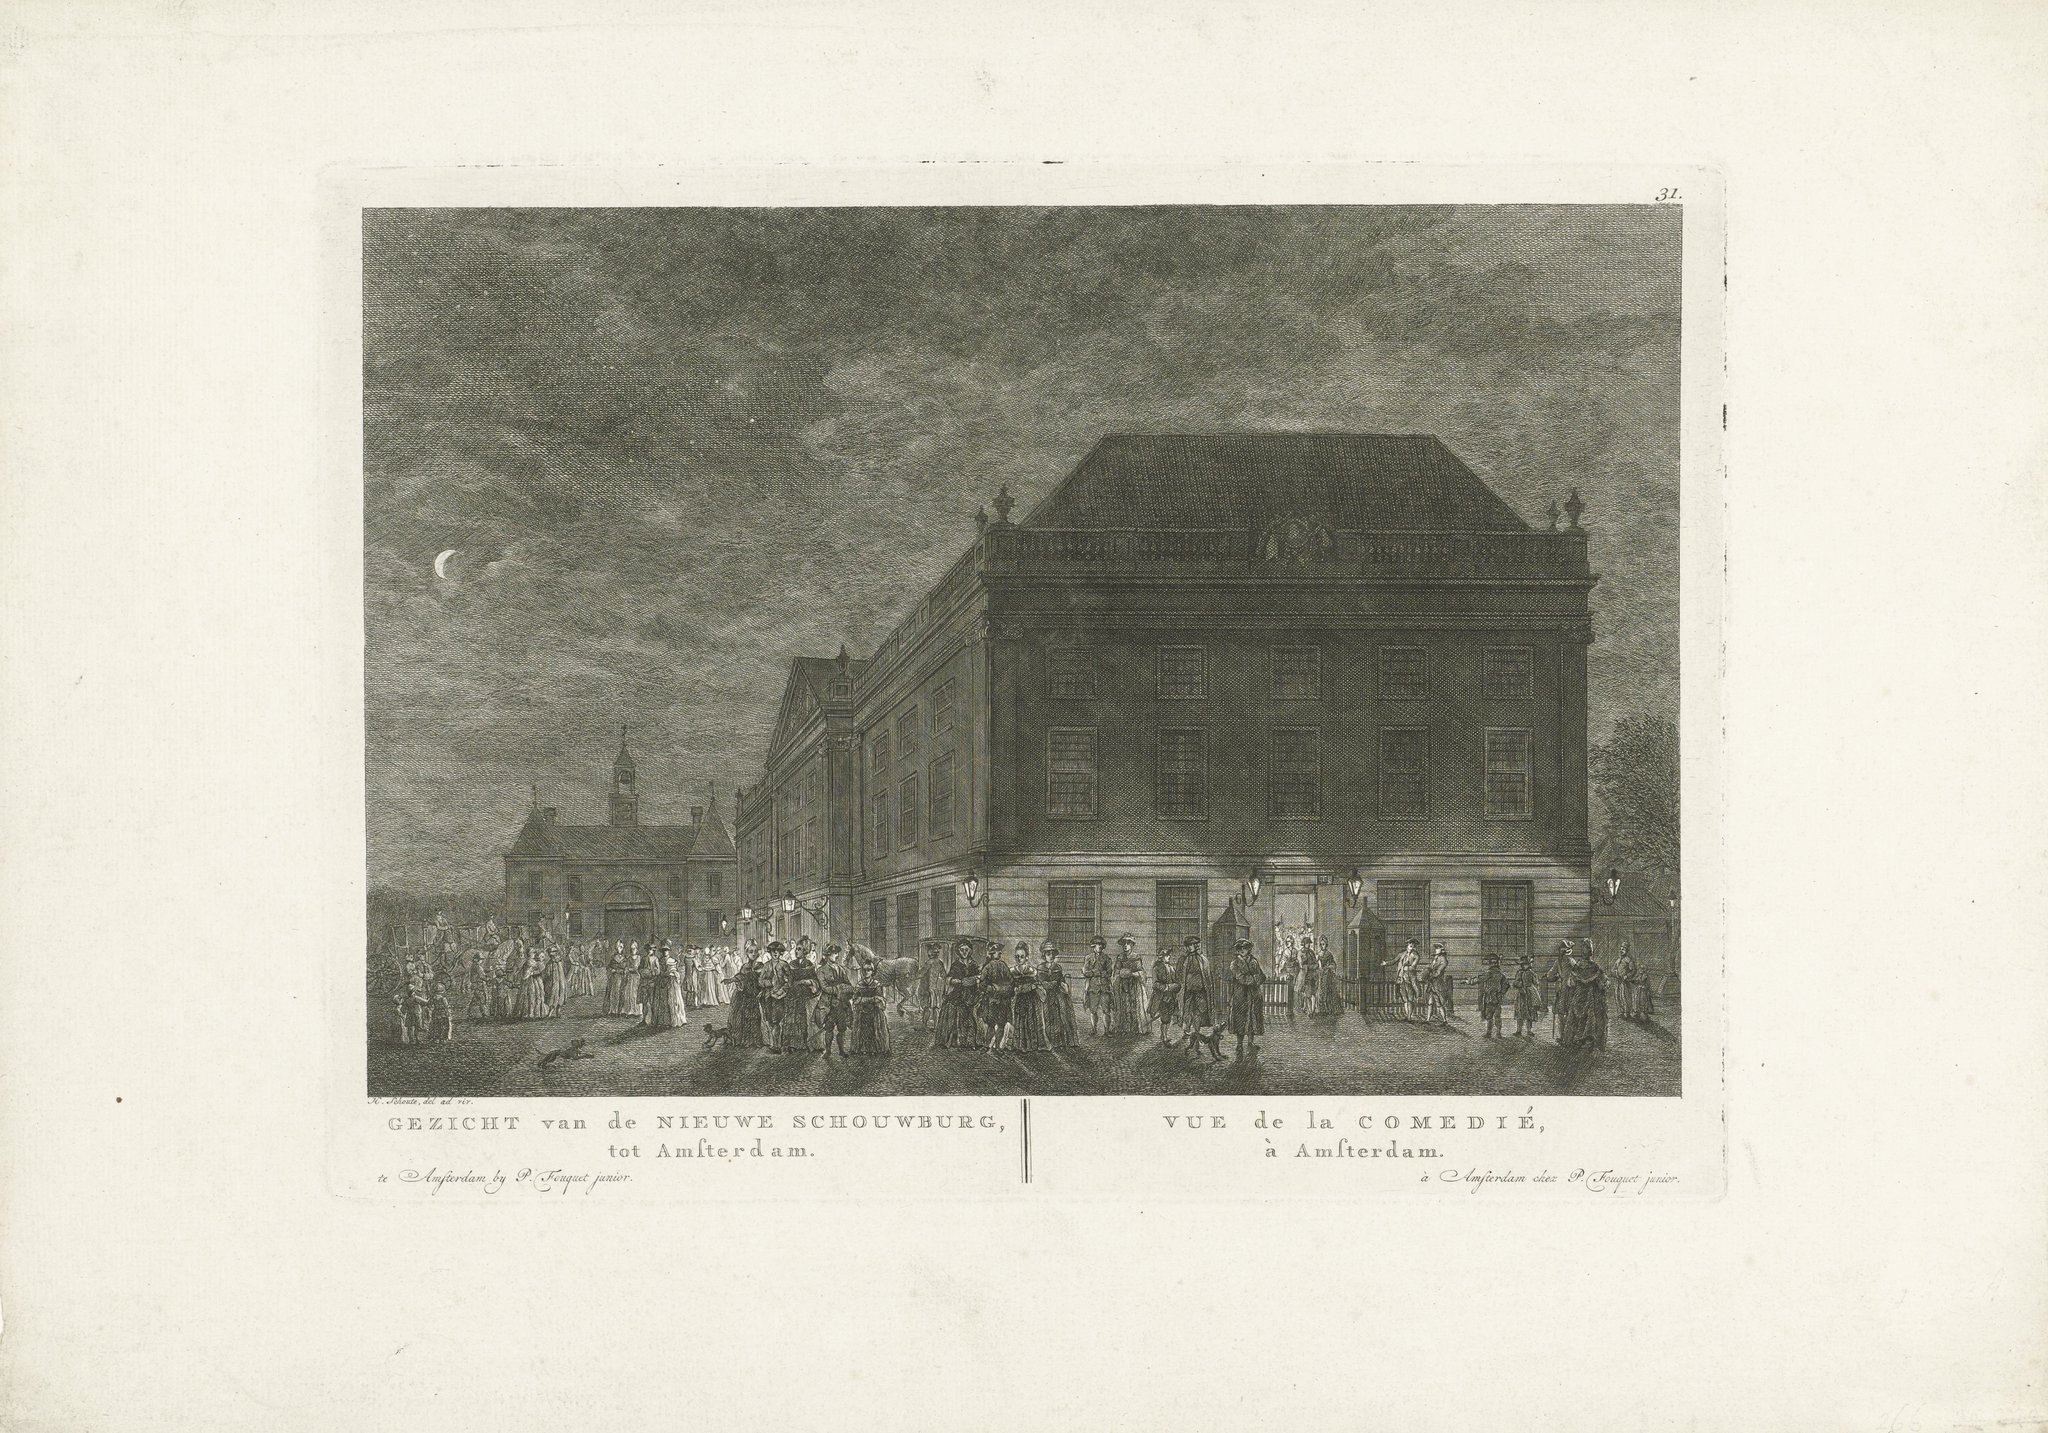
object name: print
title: Gezicht van de Nieuwe Schouwburg, tot Amsterdam / Vue de la Comedié, à Amsterdam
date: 1774-1783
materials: paper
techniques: engraving, etching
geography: amsterdam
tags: theatre (building), city-gate, square, place, circus, etc. (+ city(-scape) with figures, staffage)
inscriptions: collector's mark: Lugt 2233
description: Deze prent is ook gebruikt in de zogenaamde Atlas van Fouquet.* Pierre Fouquet gaf vanaf 1760 stadsgezichten van Amsterdam - naar tekeningen van verschillende kunstenaars, gemaakt door verschillende prentmakers - uit. Deze prenten werden aanvankelijk los of in series verkocht. Zoals toen gebruikelijk kon de koper de prenten zelf laten inbinden. Hiertoe gaf Fouquet tussen 1778 en 1783 een titelblad, plattegrond en inhoudsopgave van de tot dusver 100 uitgegeven prenten uit (1). Gezien de inhoud afhankelijk was van wat de koper had verzameld verschilt de inhoud van de verschillende bewaarde Fouquetatlassen onder deze titel sterk. Ook zijn er exemplaren bekend waar tevens andere prenten aan zijn toegevoegd. Omdat er behoefte bleek aan uitleg bij de platen werd in 1783 een nieuwe versie van de atlas uitgegeven, aangevuld met tekst en twee prenten. De aangegeven volgorde veranderde maar de platen van de al eerder uitgegeven prenten bleven ongewijzigd. Deze uitgave werd in opdracht van Fouquet gedrukt bij Daniël Jean Changuion en Petrus den Hengst (2). Een tiental platen werd bijgewerkt en verscheen, met nieuw impressum, in het vervolg van Wagenaars geschiedenis van Amsterdam, uitgeven door Petrus Conradi en Folkert van der Plaats (3). Een aantal jaar na het overlijden van Fouquet kwam Evert Maaskamp met een nieuwe uitgave van de atlas, met verbeterde tekst en toevoeging van twee prenten. Op alle platen verwijderde hij het oude en liet hij zijn eigen impressum zetten (4). De huidige staat van de prent komt voor in exemplaren van de onder (1) en (2) genoemde werken. * Onder de Atlas van Fouquet of Fouquetatlas verstaan we de hieronder vermelde publicaties (1), (2) en (4). (1). Afbeeldingen van de wyd-vermaarde koopstad Amsterdam benevens des zelvs voornaamste gebouwen en gezigten alle naar het leeven getekend / Receuil des edifices les plus considerables et des plus belles vues, de la fameuse ville d'Amsterdam, dessinées d'après nature. Amsterdam: Pierre Fouquet, 1778-1783. (2). Nieuwe atlas, van de voornaamste gebouwen en gezigten der stad Amsterdam, met derzelver beknopte beschryvingen. 2 delen. Amsterdam: Daniël Jean Changuion en Petrus den Hengst [in opdracht van Pierre Fouquet], 1783. (3). Stijl, Simon. Amsterdam, in zyne geschiedenissen, voorregten, koophandel, gebouwen, kerkenstaat, schoolen, schutterye, gilden en regeeringe, beschreeven. Om te dienen ten vervolge op het werk van Jan Wagenaar (…). 10 delen. Amsterdam en Harlingen: Petrus Conradi en Folkert van der Plaats, 1788-1801. (4). Nieuwe atlas, van de voornaamste gebouwen en gezigten der stad Amsterdam. Met derzelver beknopte beschryvingen. Amsterdam: Evert Maaskamp, 1805. * Het aantal vermelde staten is gebaseerd op het aantal gevonden staten. Mogelijk zijn er meer staten van deze prent.